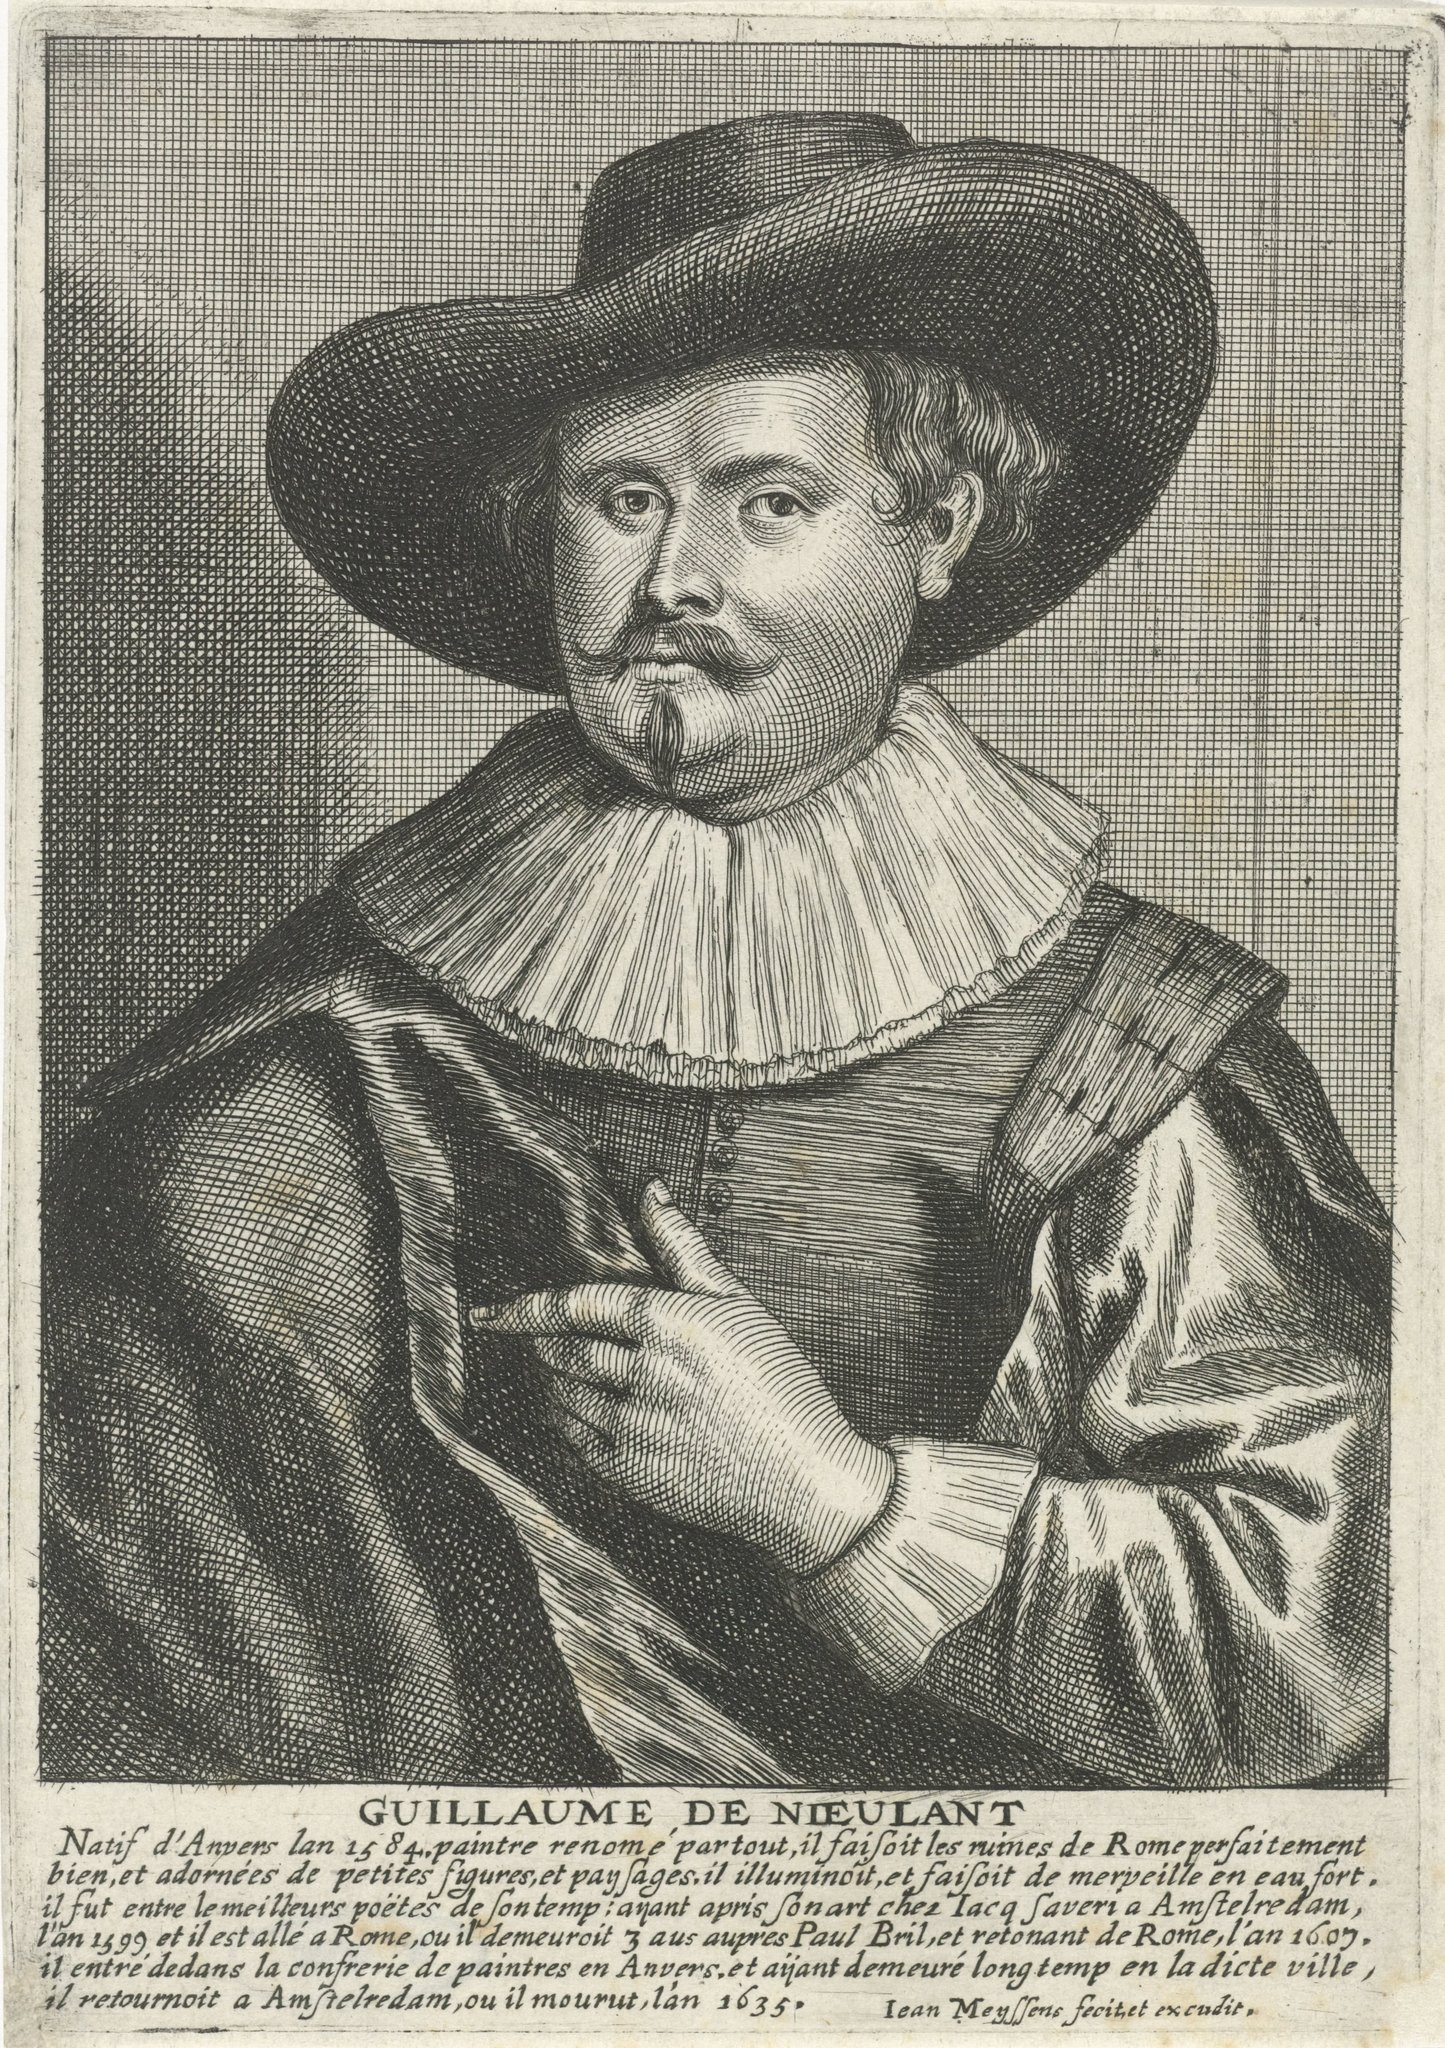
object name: book illustration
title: Portret van Willem van Nieulandt (II)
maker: joannes meyssens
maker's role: print maker, publisher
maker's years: 1612-1670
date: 1662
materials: paper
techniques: engraving, etching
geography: antwerp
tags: antwerp, amsterdam, print maker, draughtsman, guilliam van nieulandt (ii), portrait, self-portrait of artist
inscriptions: collector's mark: Lugt 2228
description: Portret van Willem van Nieulandt (II), schilder en prentmaker, met een hoed op zijn hoofd. Onderaan in de marge een zesregelige tekst over zijn werkzaamheden in het Frans.